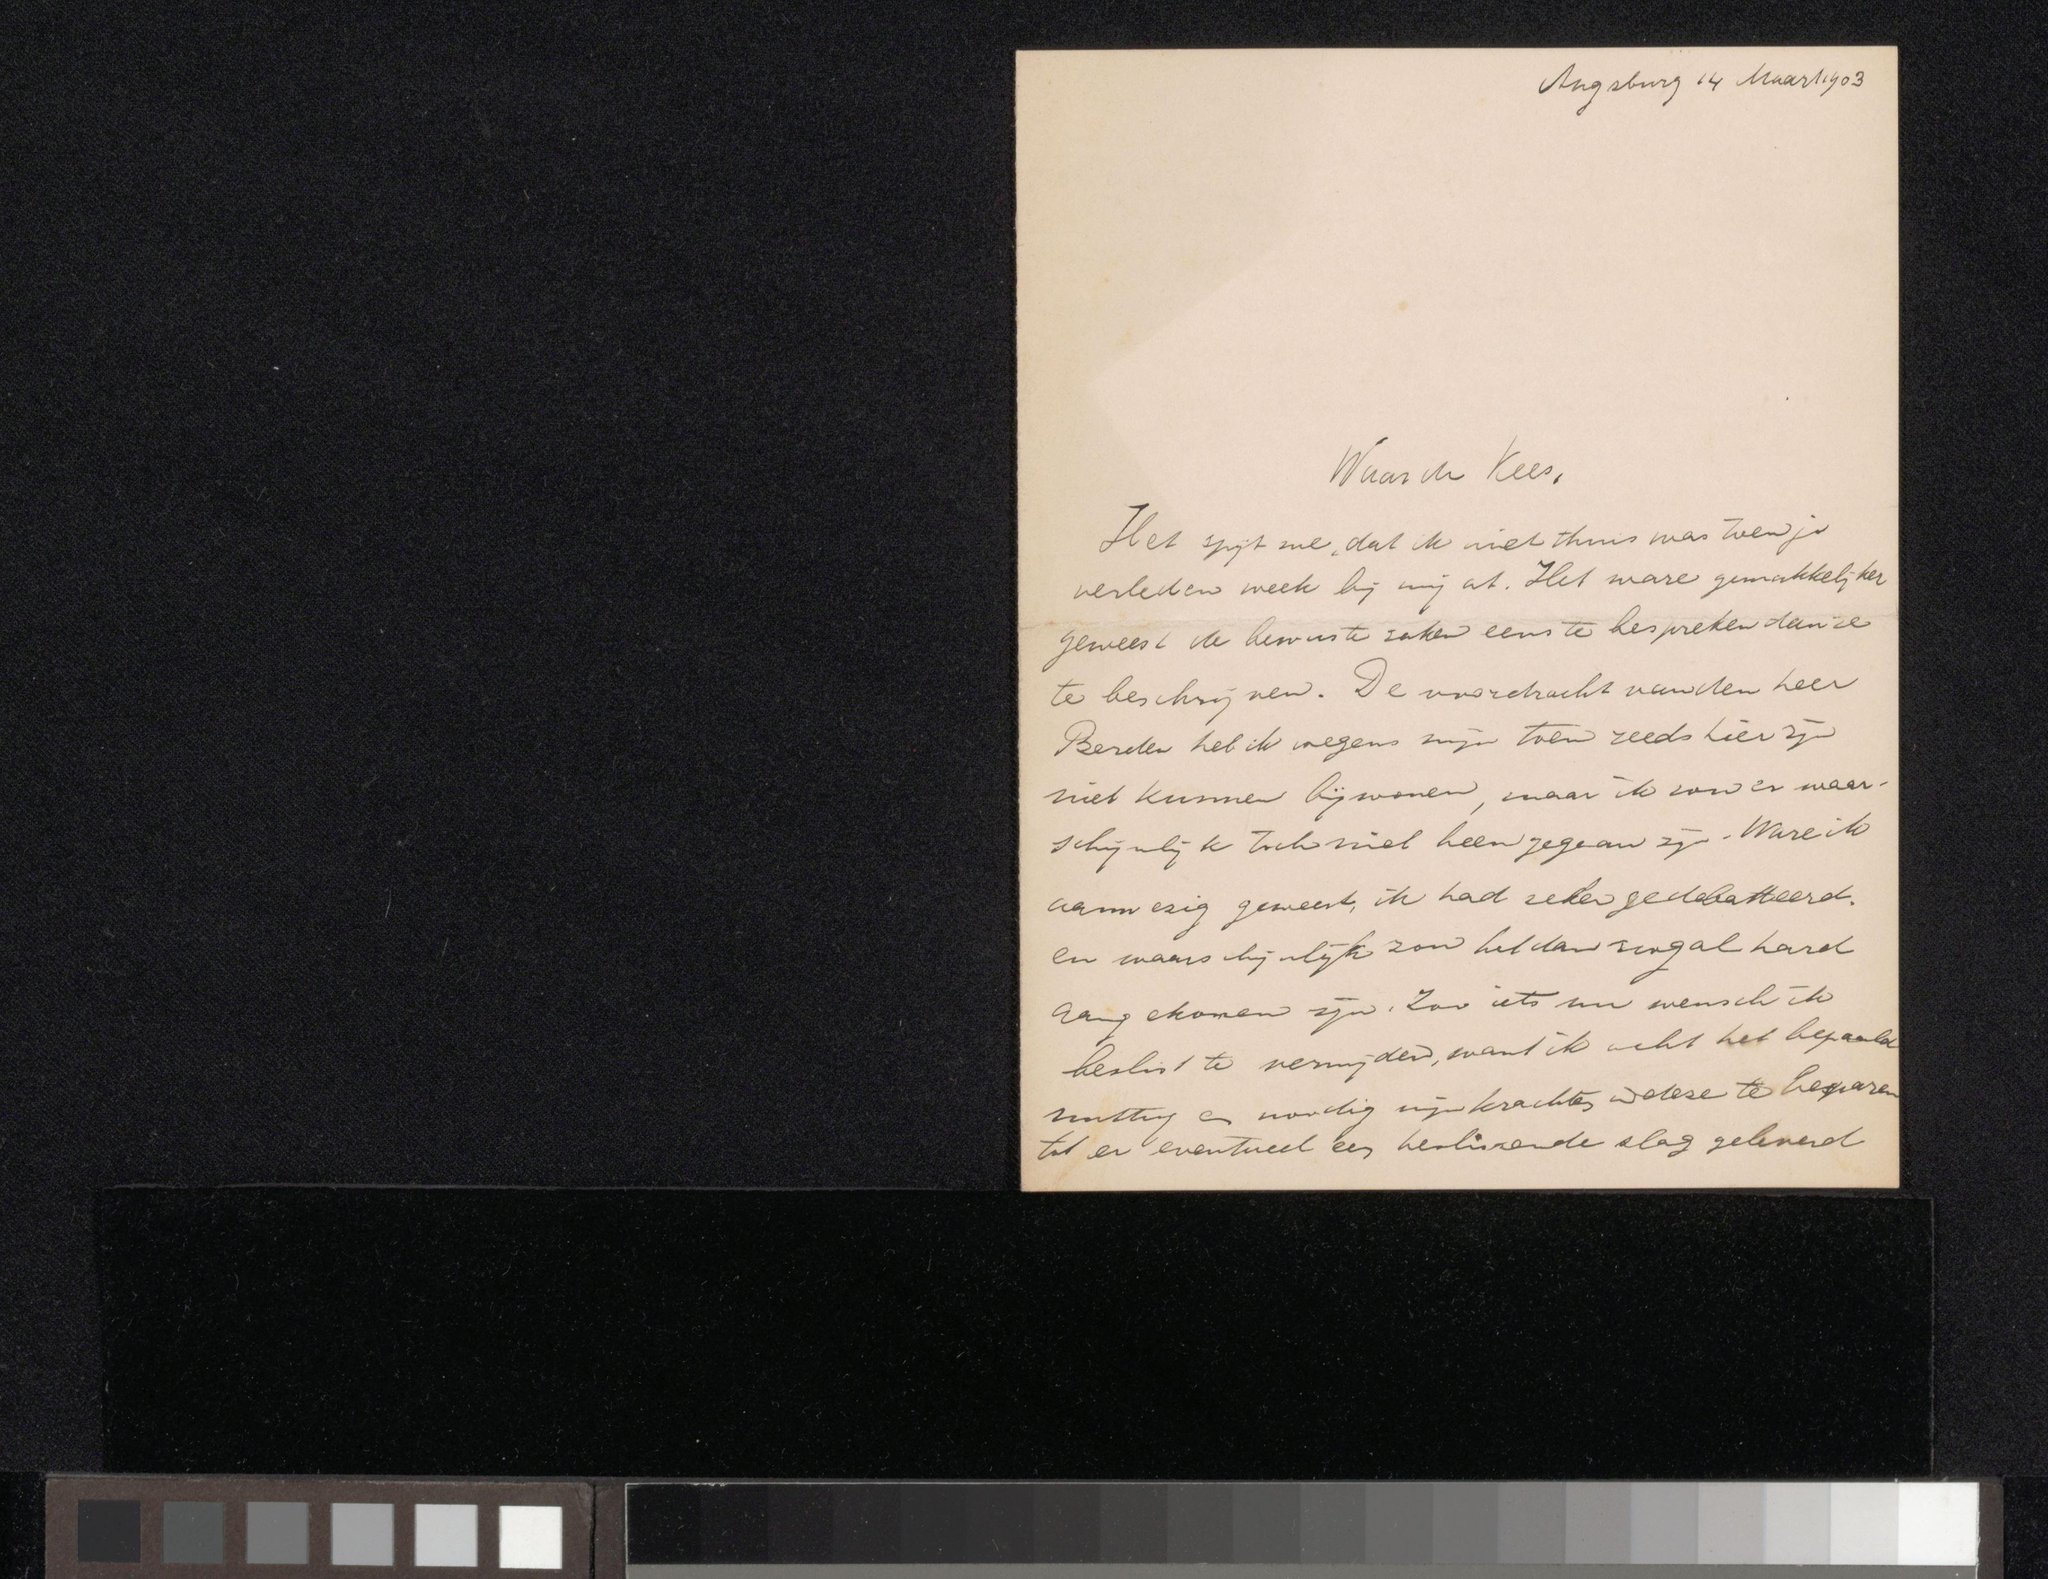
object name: letter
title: Brief aan Cornelius Gerardus 't Hooft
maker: jan veth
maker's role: designer, draughtsman, painter, print maker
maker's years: 1864-1925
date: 1903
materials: ink, paper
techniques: pen, writing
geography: augsburg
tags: rotterdam, george hendrik breitner, jacob willem hubert berden, pierre joseph hubert cuypers, abraham bredius, dordrecht, amsterdam, painter, draughtsman, cornelis gerardus 't hooft, sculpture, architecture, money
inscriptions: watermark, collector's mark: ‘RPK’